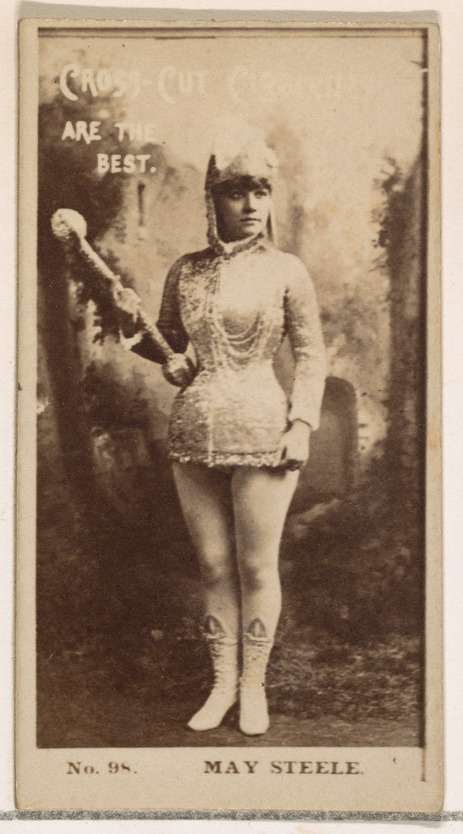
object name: print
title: Card Number 98, May Steele, from the Actors and Actresses series (N145-2) issued by Duke Sons & Co. to promote Cross Cut Cigarettes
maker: w. duke, sons & co.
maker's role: publisher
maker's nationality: american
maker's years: 1870-1920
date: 1880-1889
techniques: albumen silver print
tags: portraits,women,actresses